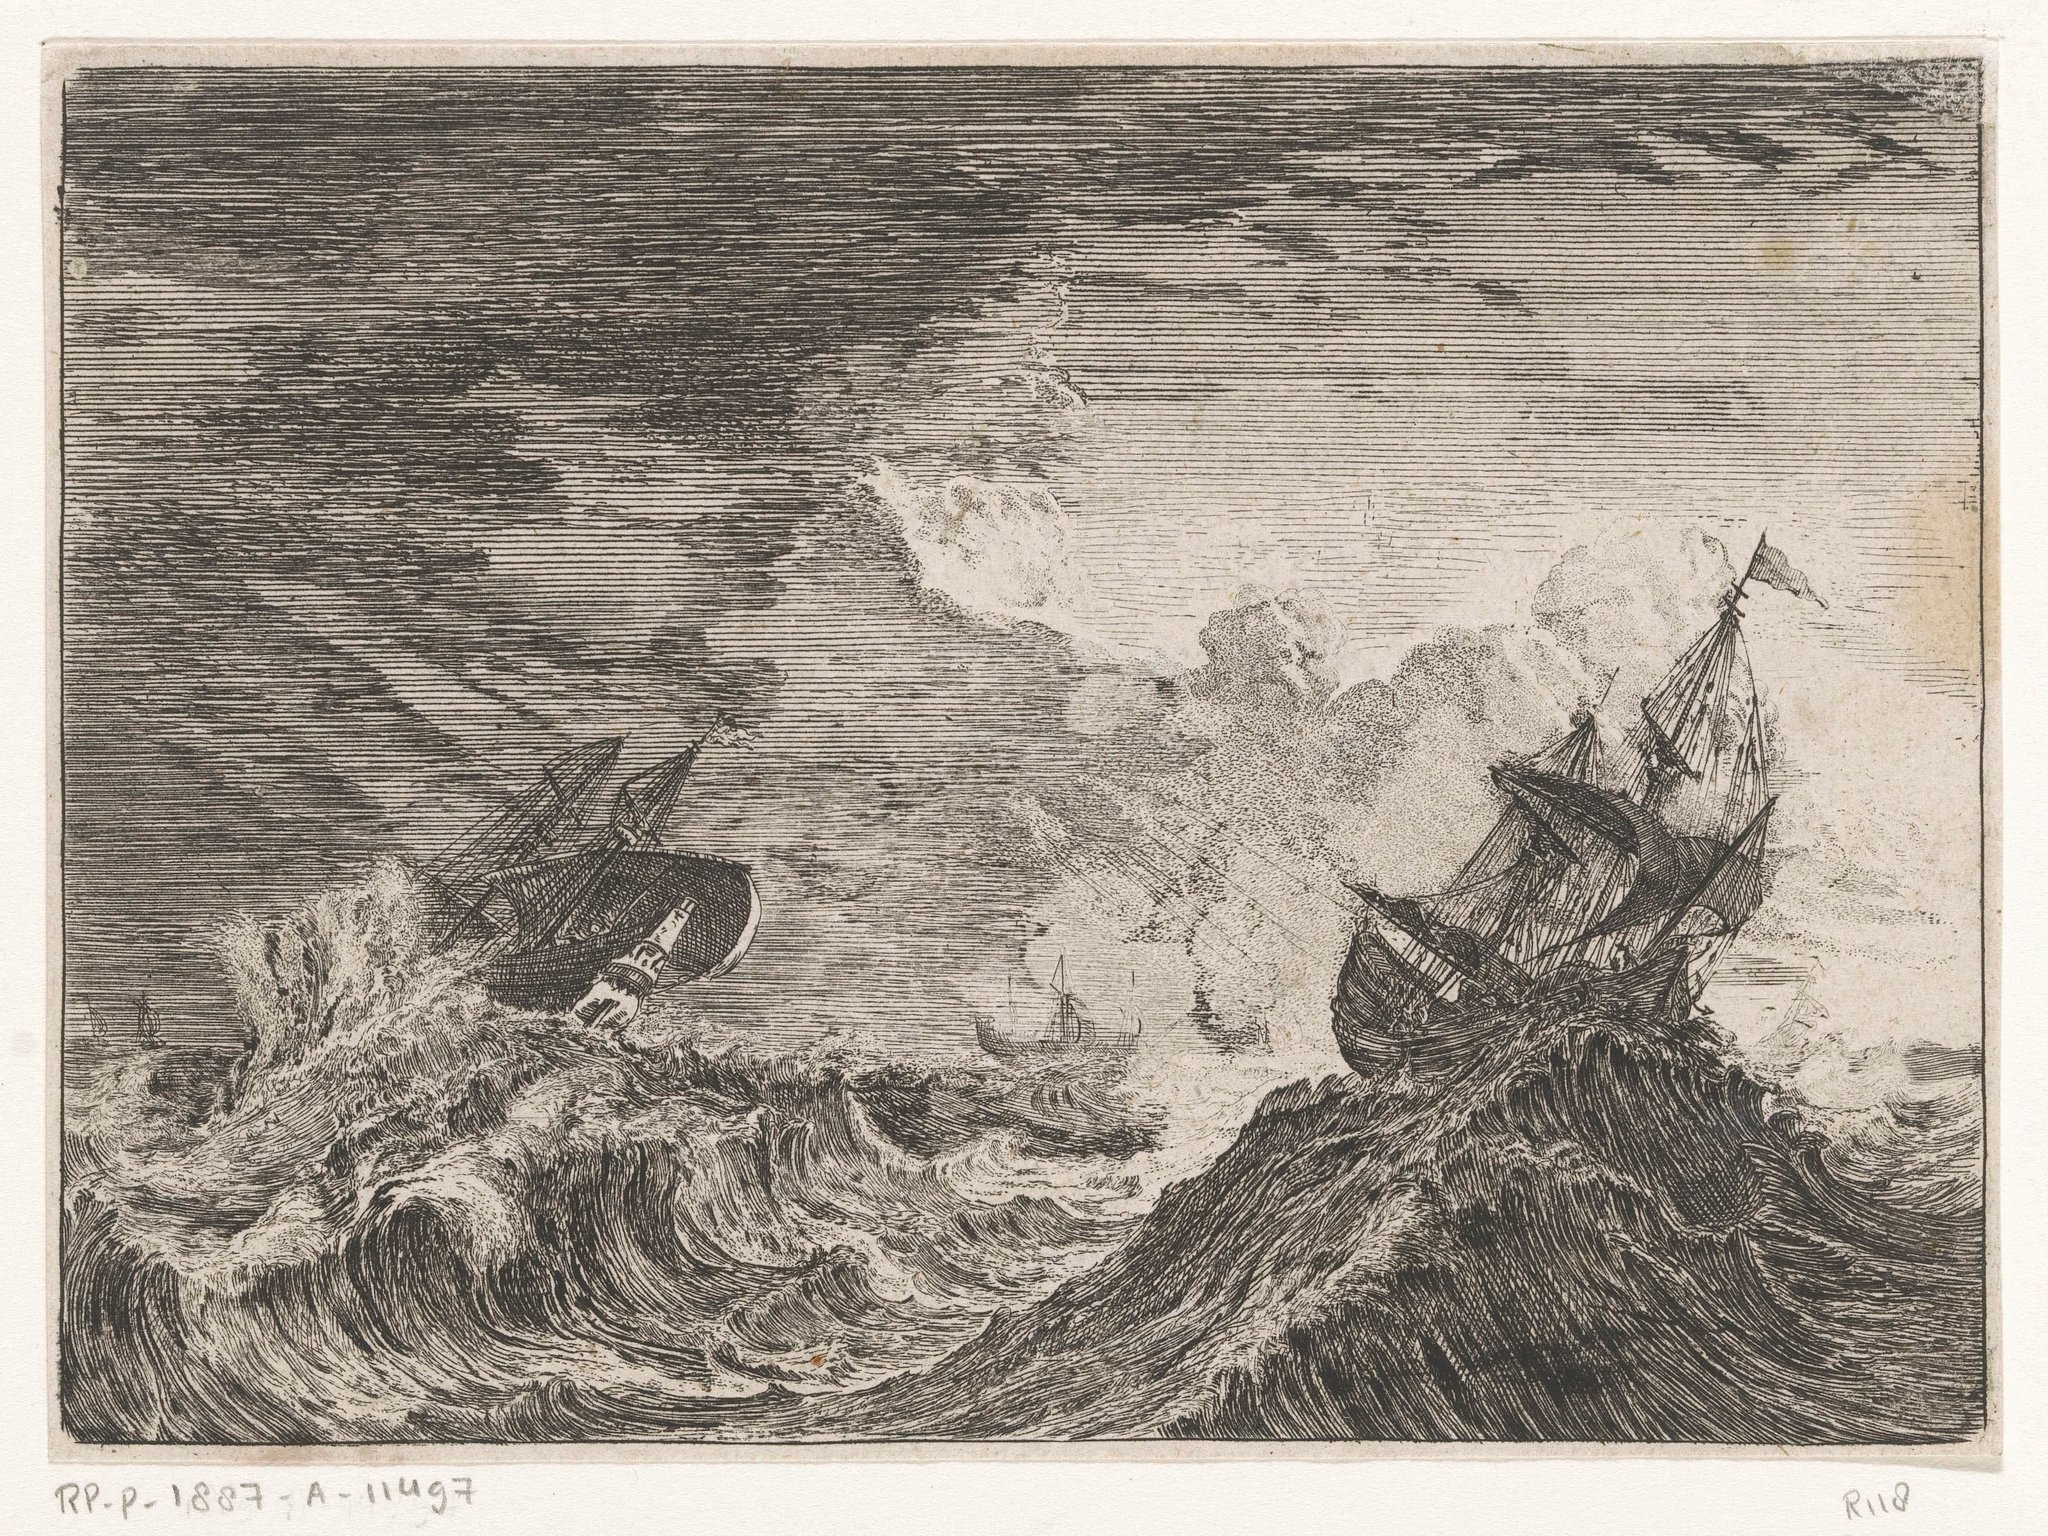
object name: print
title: Twee zeilschepen opgetild door de golven tijdens een storm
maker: johann wilhelm baur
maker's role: draughtsman, painter, print maker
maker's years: 1607-1642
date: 1640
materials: paper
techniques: etching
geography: vienna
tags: sailing-ship, sailing-boat, storm at sea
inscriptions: collector's mark: Lugt 2228, annotation: ‘hierna heb ik de (...) / (...) was door een / duitsch etser. - op een de / platen staet de naam de / prenten zijn in de RBH genommerd / J[ohan] Ph[ilip] vd K[ellen]’, collector's mark: Lugt 2228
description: Vierde prent uit de serie 'Schepen in stormachtig weer', bestaand uit vier genummerde prenten. Door een restauratie in de rechterbovenhoek is het nummer weggevallen. Van deze serie bestaan ook latere drukken, uitgegeven te Augsburg door Joachim Wolf en de erven van Johann Michael Probst.